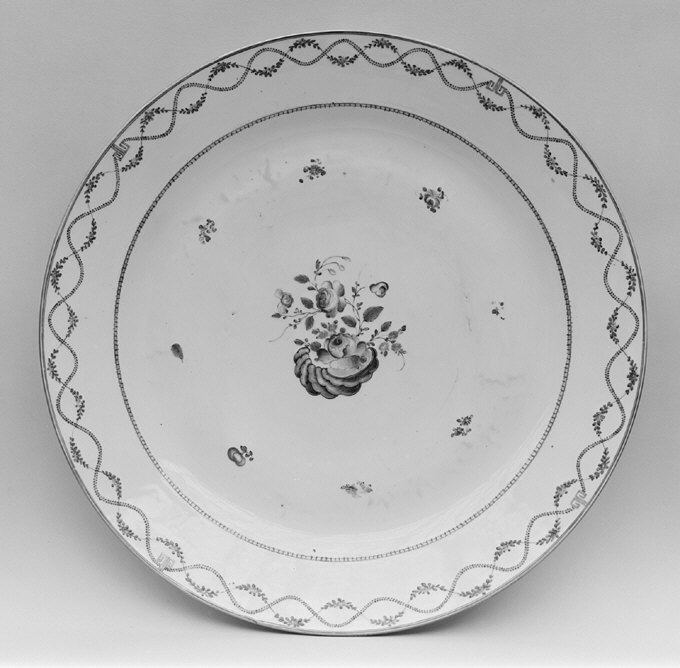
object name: platter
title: Platter (part of a service)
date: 1790-1800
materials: hard paste porcelain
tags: roses